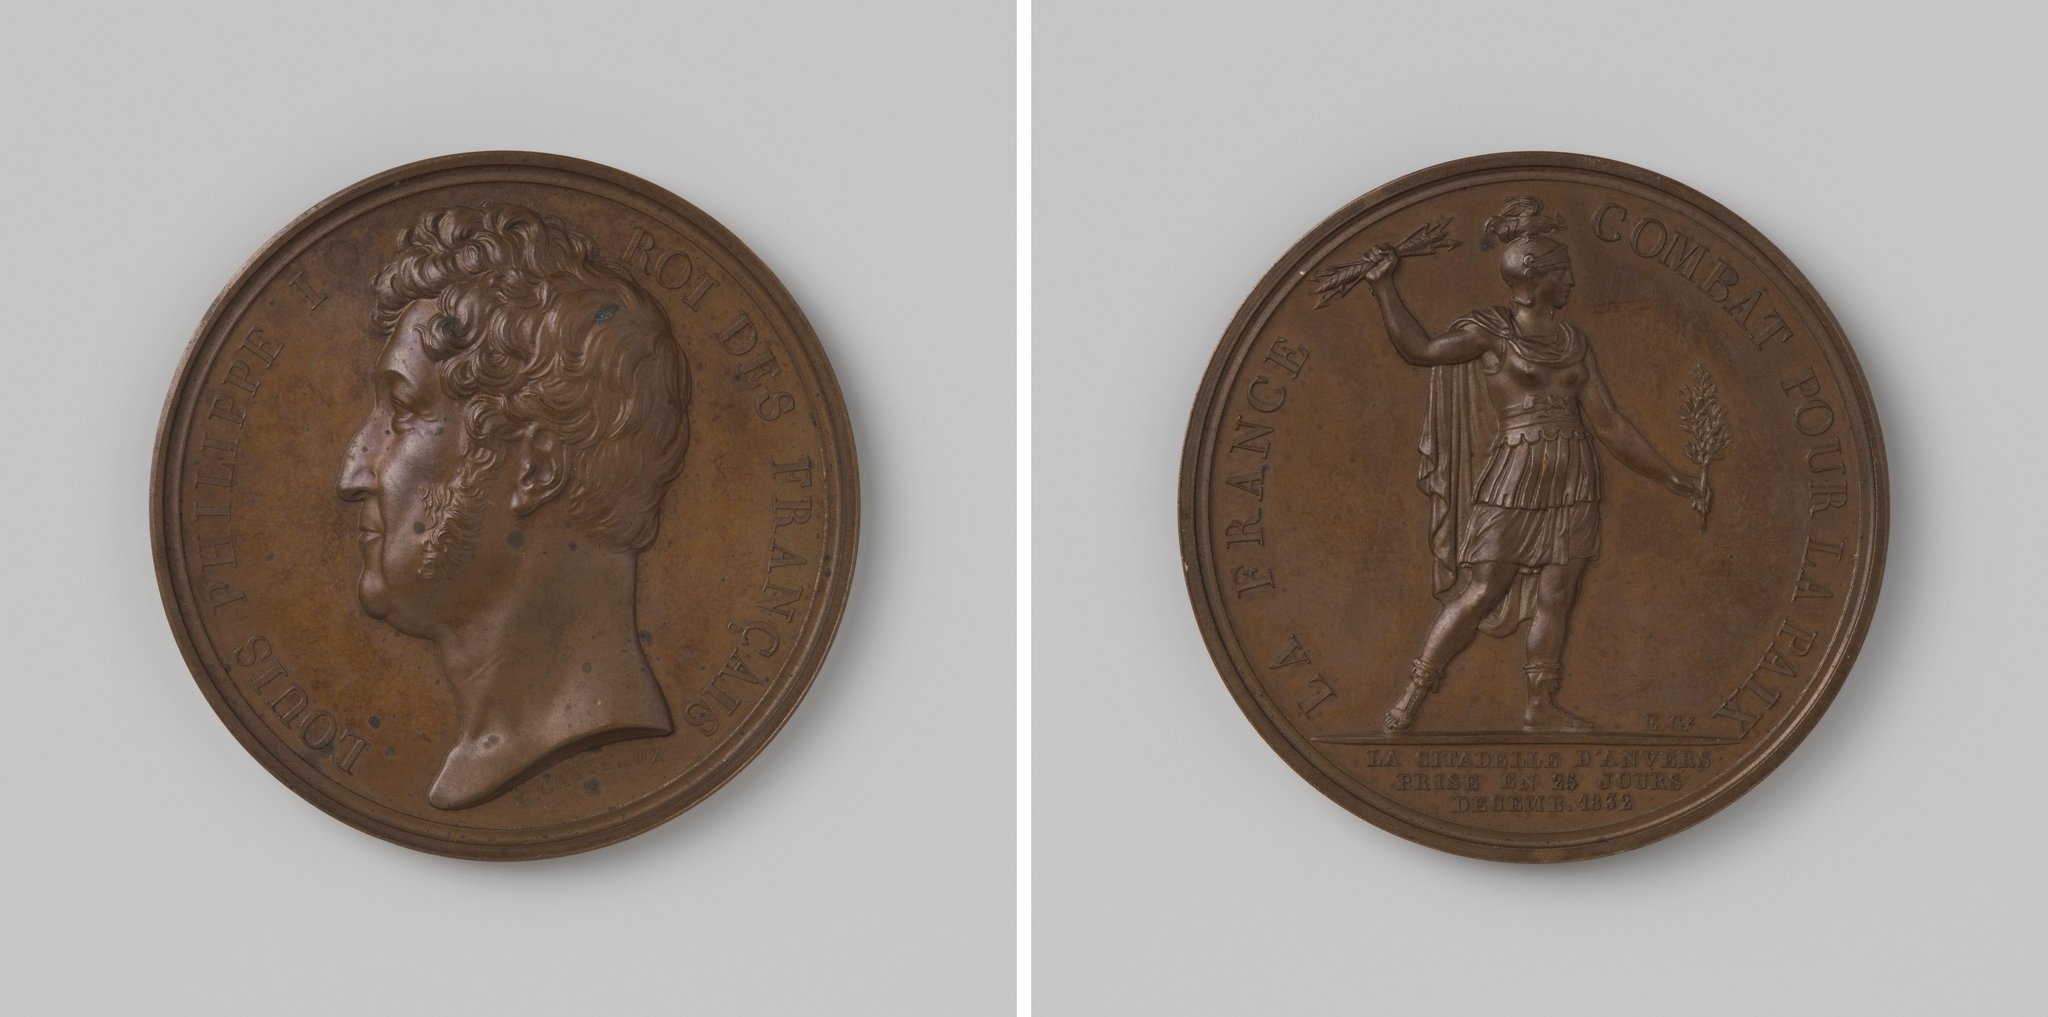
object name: history medal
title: Verovering van de citadel van Antwerpen, ter ere van Lodewijk Filips, koning der Fransen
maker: jacques edouard gatteaux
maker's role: sculptor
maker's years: 1788-1881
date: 1832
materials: bronze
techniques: striking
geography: paris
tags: lodewijk filips i (koning van frankrijk)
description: Bronzen penning. Voorzijde: borststuk man binnen omschrift. Keerzijde: gehelmde vrouw in Romeinse wapenrusting, voorstellende Frankrijk, houdt in rechterhand bliksemschichten boven haar hoofd en in linkerhand olijftak binnen omschrift; afsnede: opschrift.